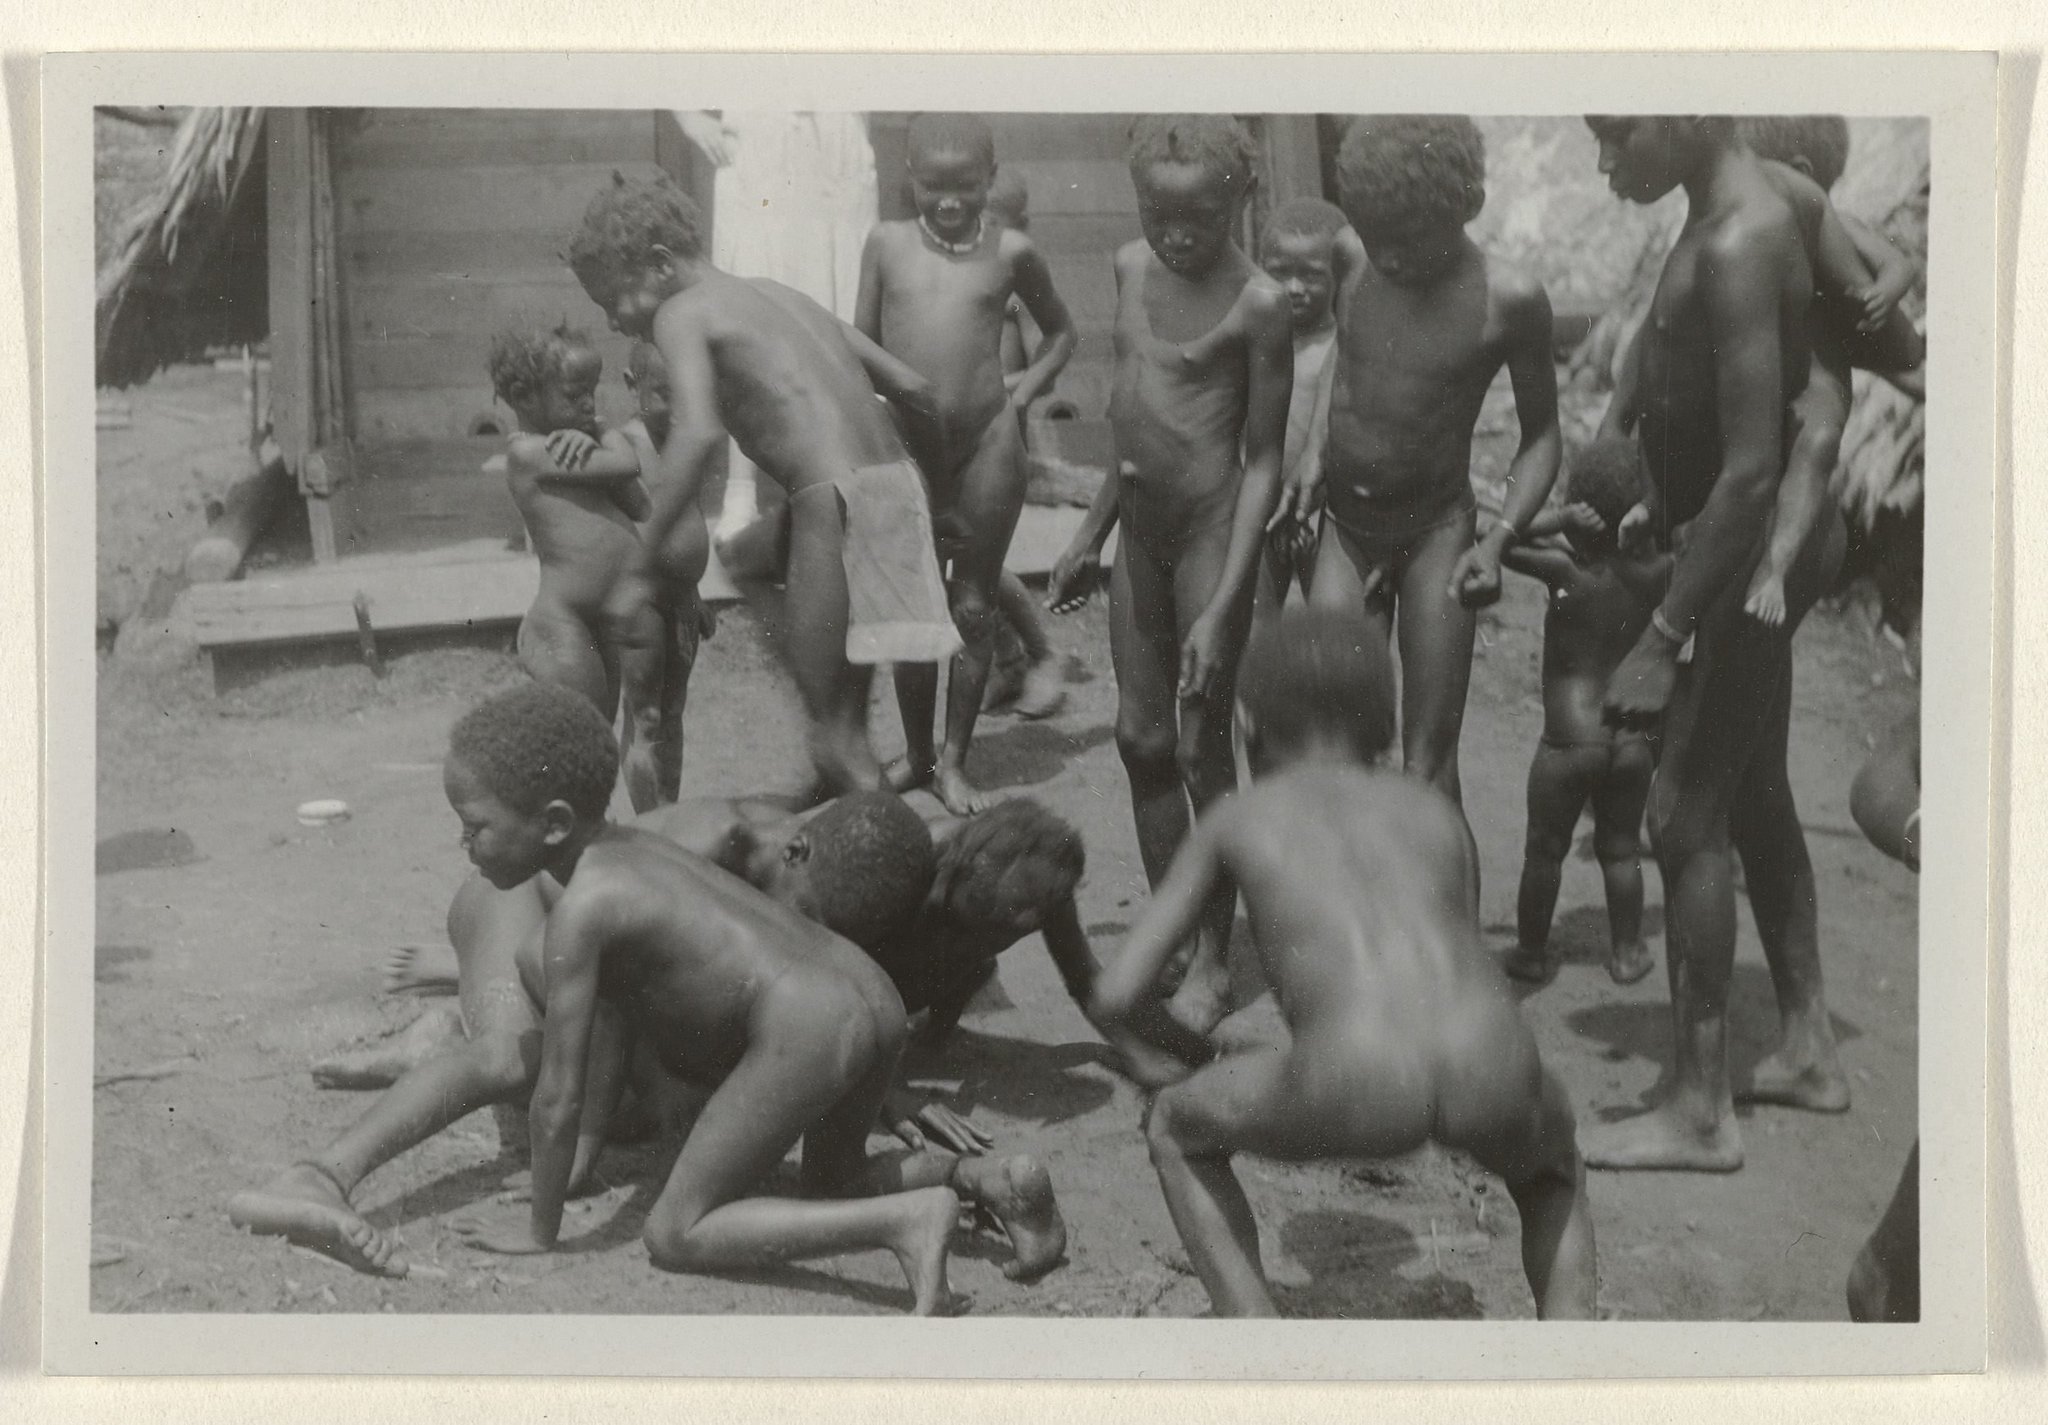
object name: photograph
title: Spelende Surinaamse jongetjes in het binnenland van Suriname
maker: Anonymous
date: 1929-1930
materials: photographic support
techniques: photography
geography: suriname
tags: children's games and plays, village